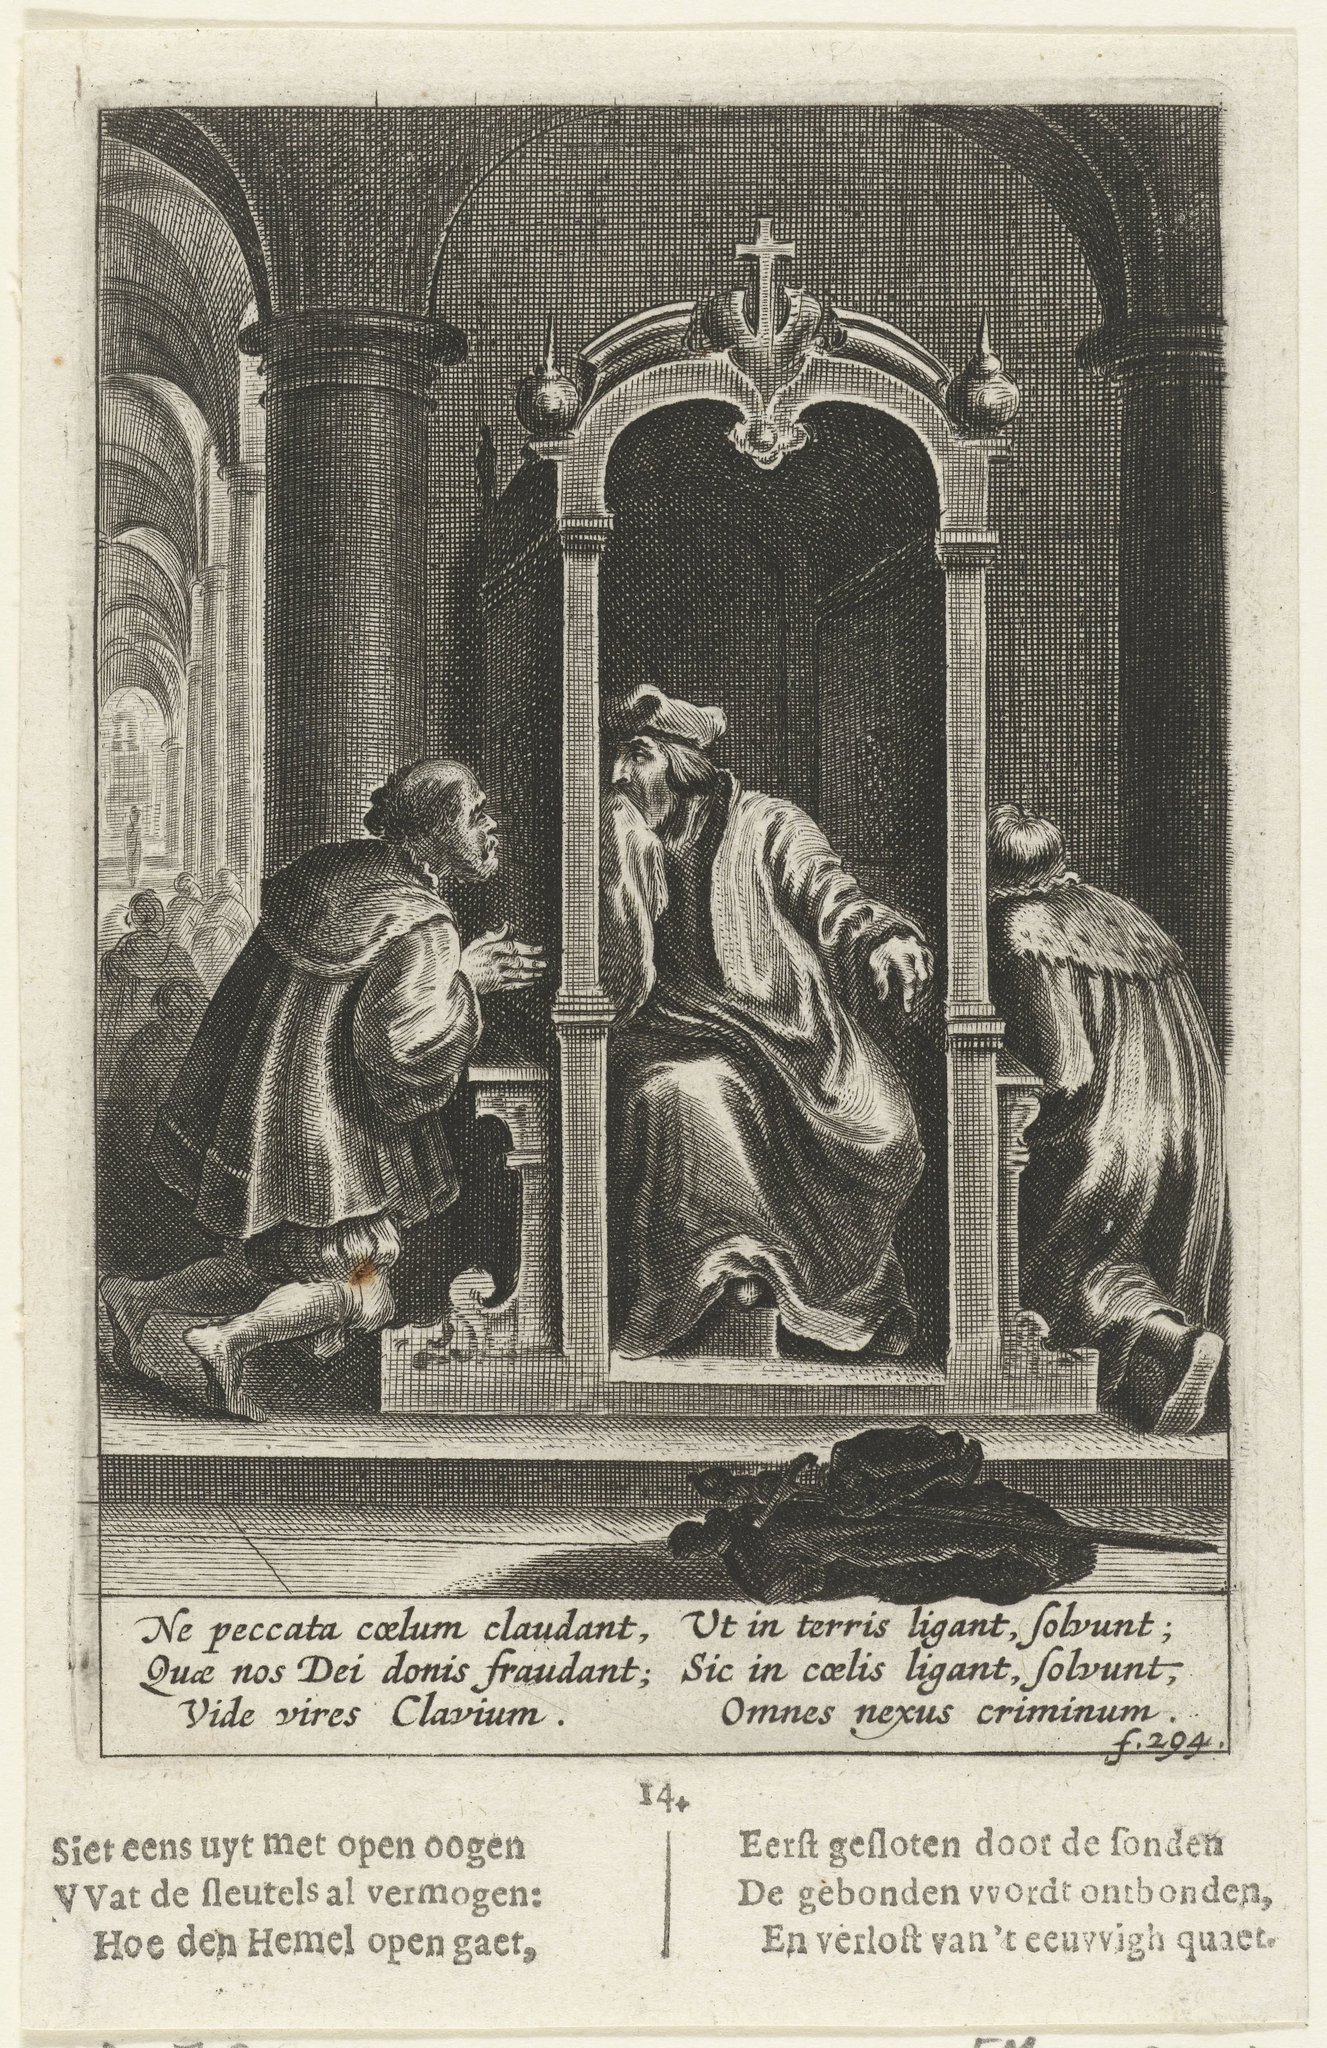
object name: print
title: Het Mirakel van Amsterdam (kopie), 1345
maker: Anonymous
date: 1639-1699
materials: paper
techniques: engraving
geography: low countries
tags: confession; 'confessione sacramentale' (ripa) ~ the third of the seven sacraments, amsterdam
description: Een priester neemt de biecht af. Prent nr. 14 uit de serie van 16 voorstellingen van Het Mirakel van Amsterdam, naar de gebeurtenissen op 15 maart 1345. Kopieën naar de reeks van Bolswert. Onder de voorstelling in de plaat gegraveerd een zesregelig vers in het Latijn, daaronder een zesregelig vers in boekdruk in het Nederlands.